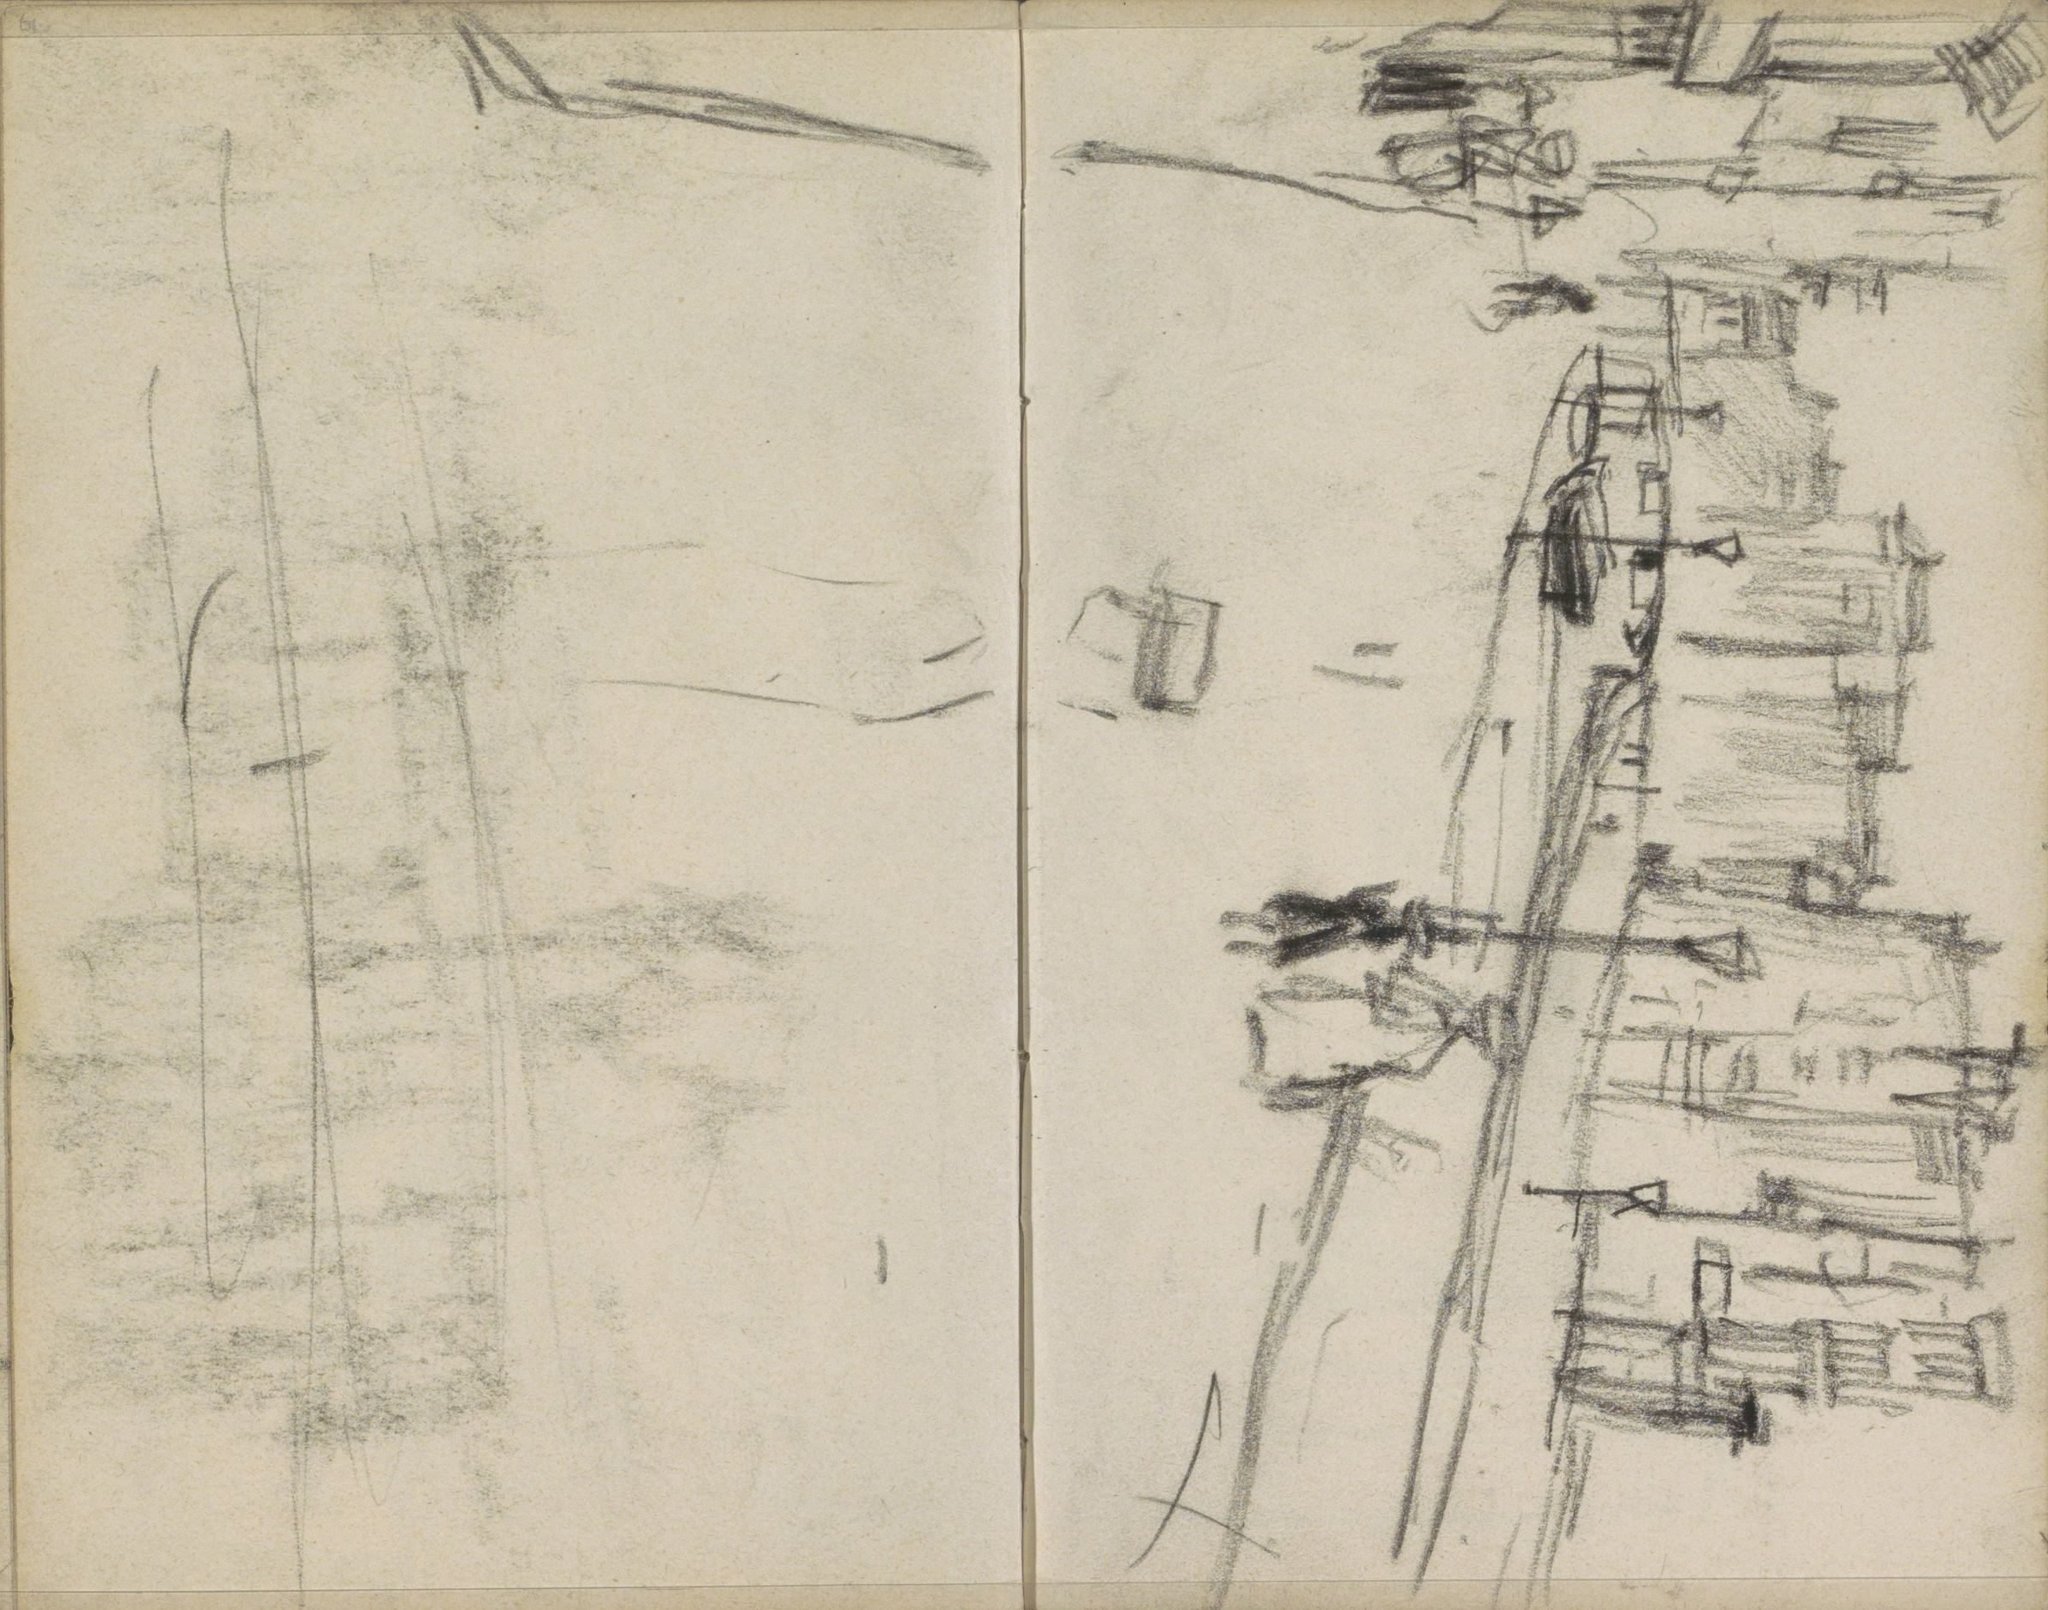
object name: sketchbook leaf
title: Gezicht op het Rokin te Amsterdam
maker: george hendrik breitner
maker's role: draughtsman, painter, print maker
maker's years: 1857-1923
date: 1900-1923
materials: chalk, paper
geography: amsterdam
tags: urban housing, canals, waters (in city) (+ city(-scape) with figures, staffage)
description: Mogelijk gezien vanuit Rokin 93, de voormalige kapel van het Sint-Mariaklooster. Pagina 61 en pagina 62 uit een schetsboek met 39 bladen.